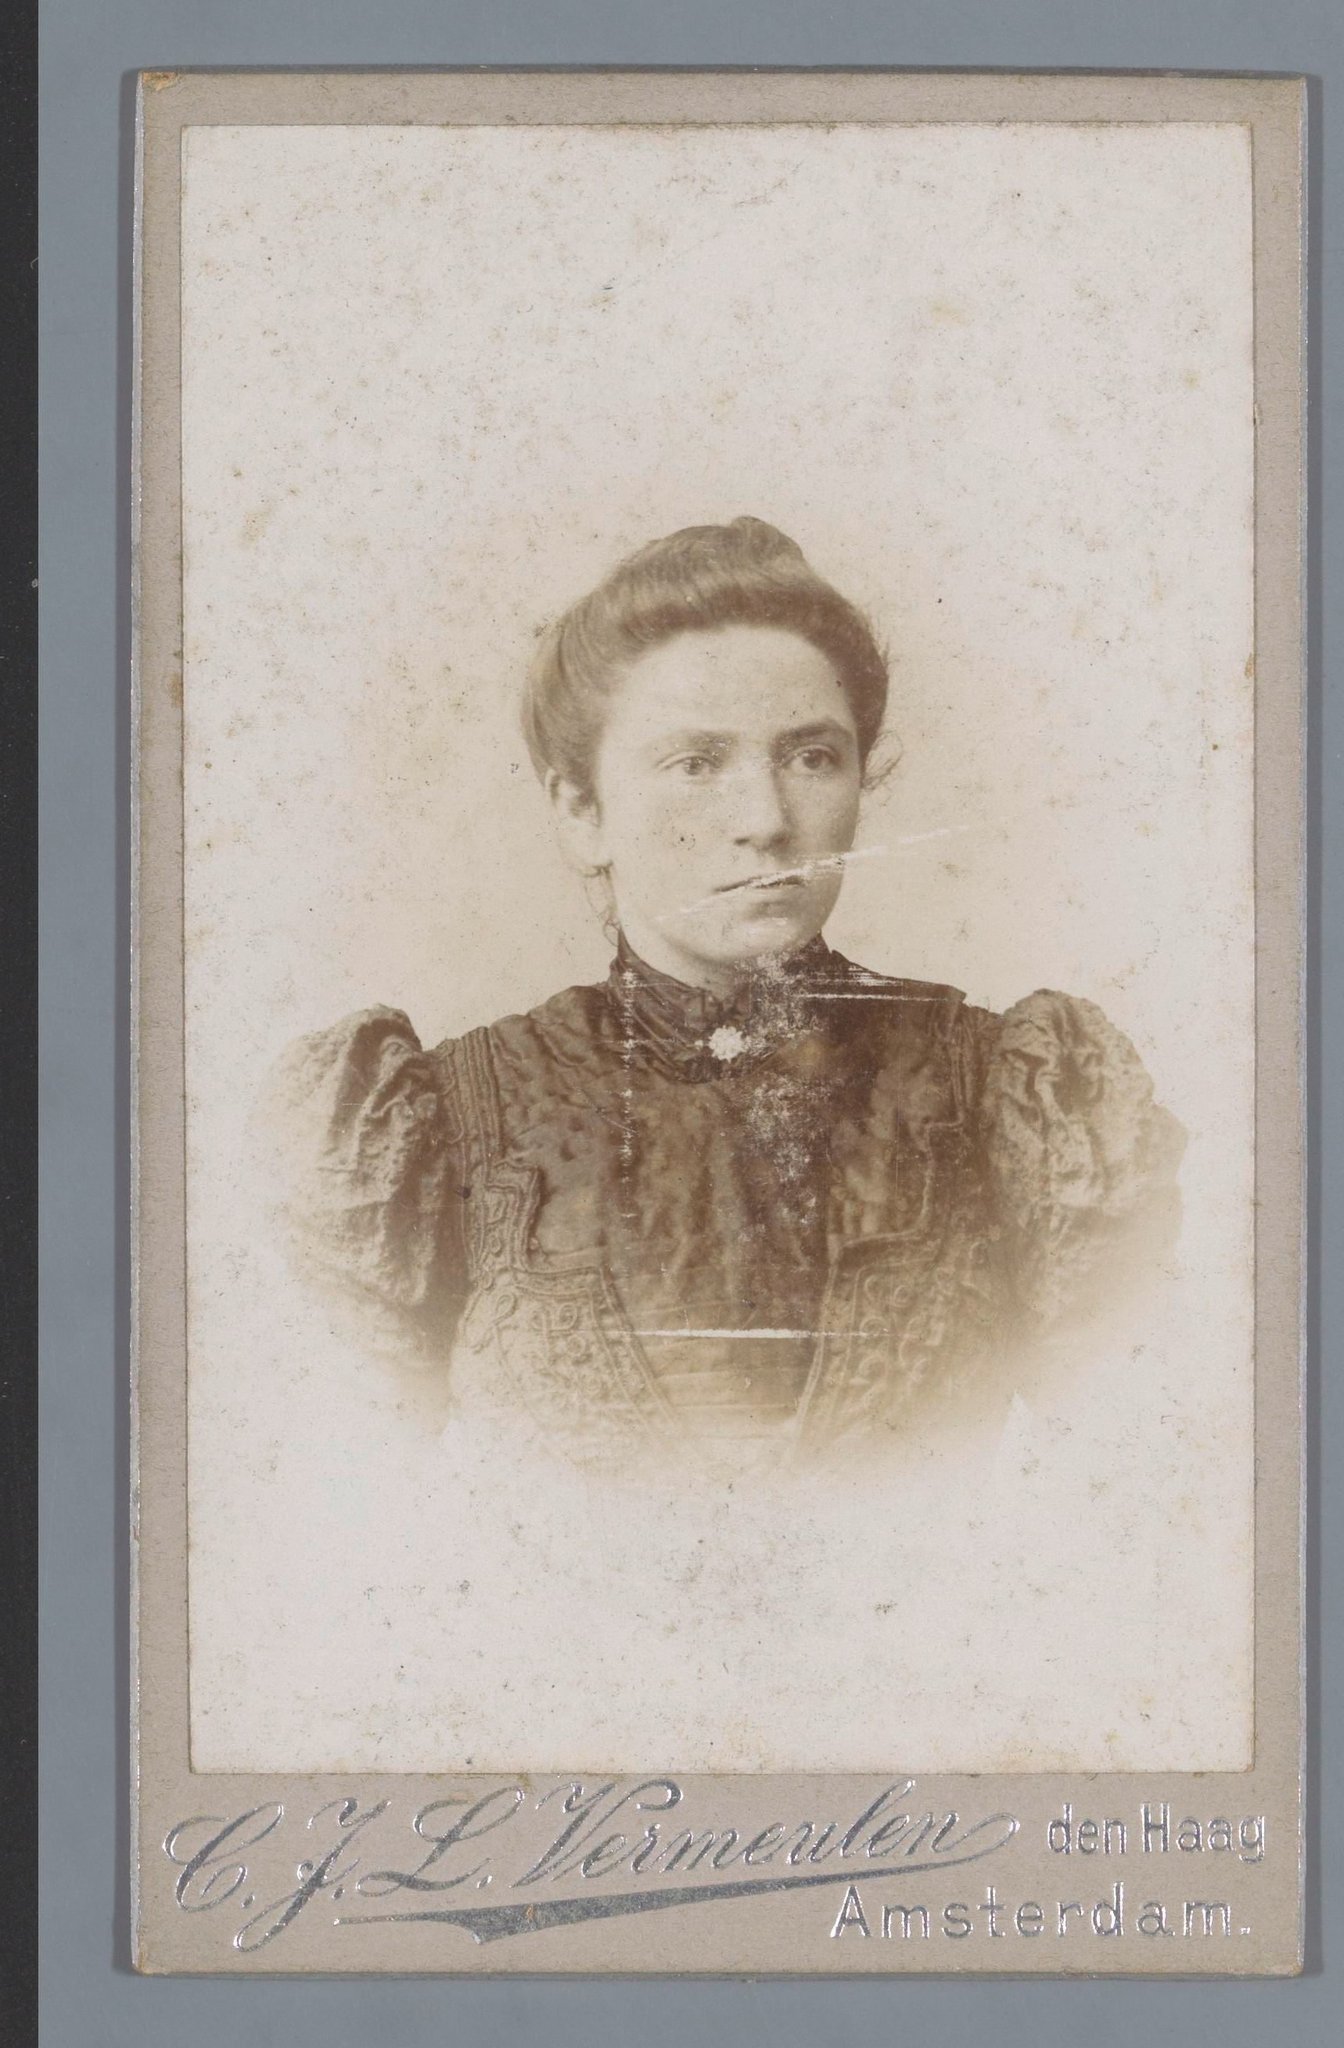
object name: carte de visite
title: Portret van een onbekende vrouw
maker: cornelis johannes lodewicus vermeulen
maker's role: fotograaf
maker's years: 1861-1936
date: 1888-1915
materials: cardboard, paper, photographic support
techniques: collodion silver print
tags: adult woman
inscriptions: inscription: ‘C.J.L. Vermeulen Heerenstraat 6, Heiligenweg hoek Singel Amsterdam Telephoon No. 2339 en 2340. Toussaintkade 11. den Haag. Intercommunal Telephoon: 774.’, name: ‘C.J.L. Vermeulen den Haag Amsterdam.’